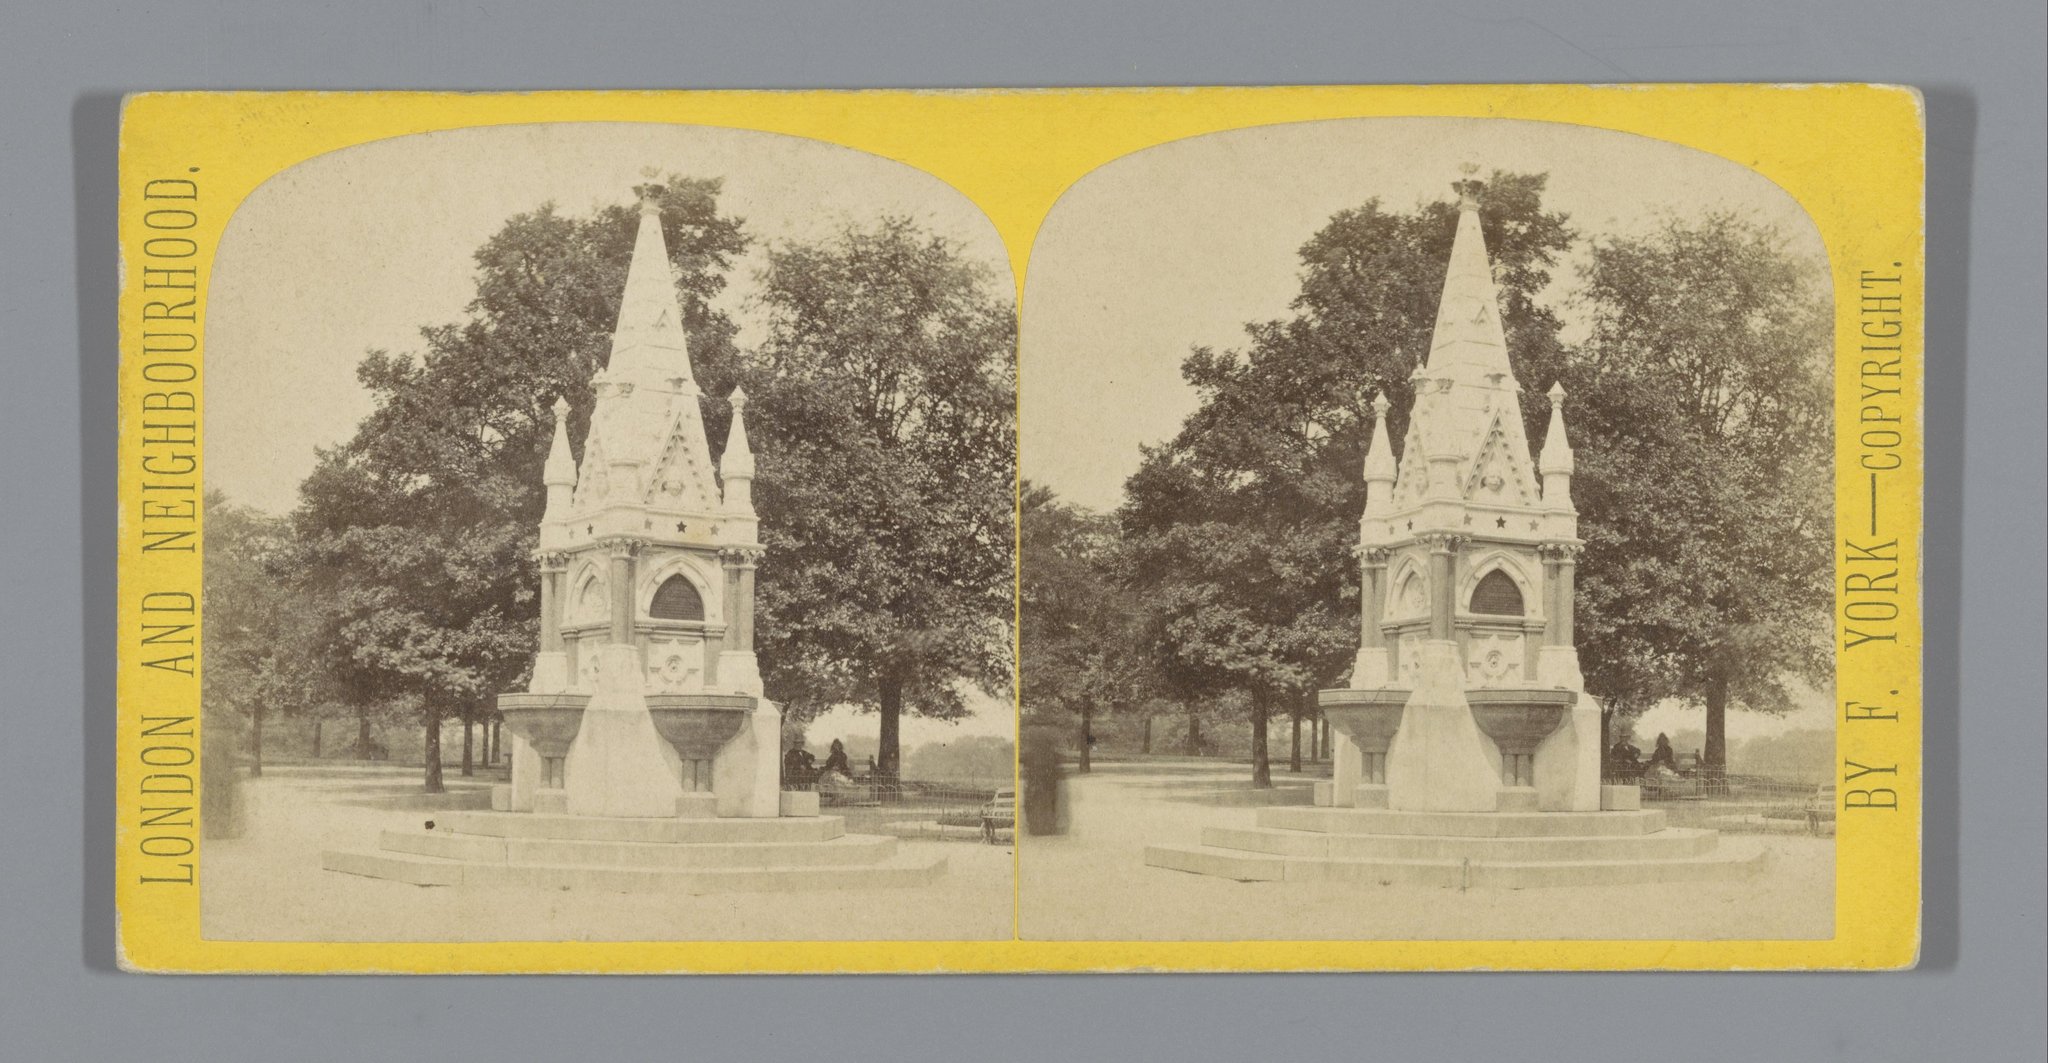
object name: stereograph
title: Ready Money's Fountain in Regent's Park in Londen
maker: frederick york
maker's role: fotograaf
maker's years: 1823-1903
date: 1860-1880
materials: cardboard, photographic support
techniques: albumen print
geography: regent's park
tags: ornamental fountain (in village)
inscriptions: number: ‘332.’